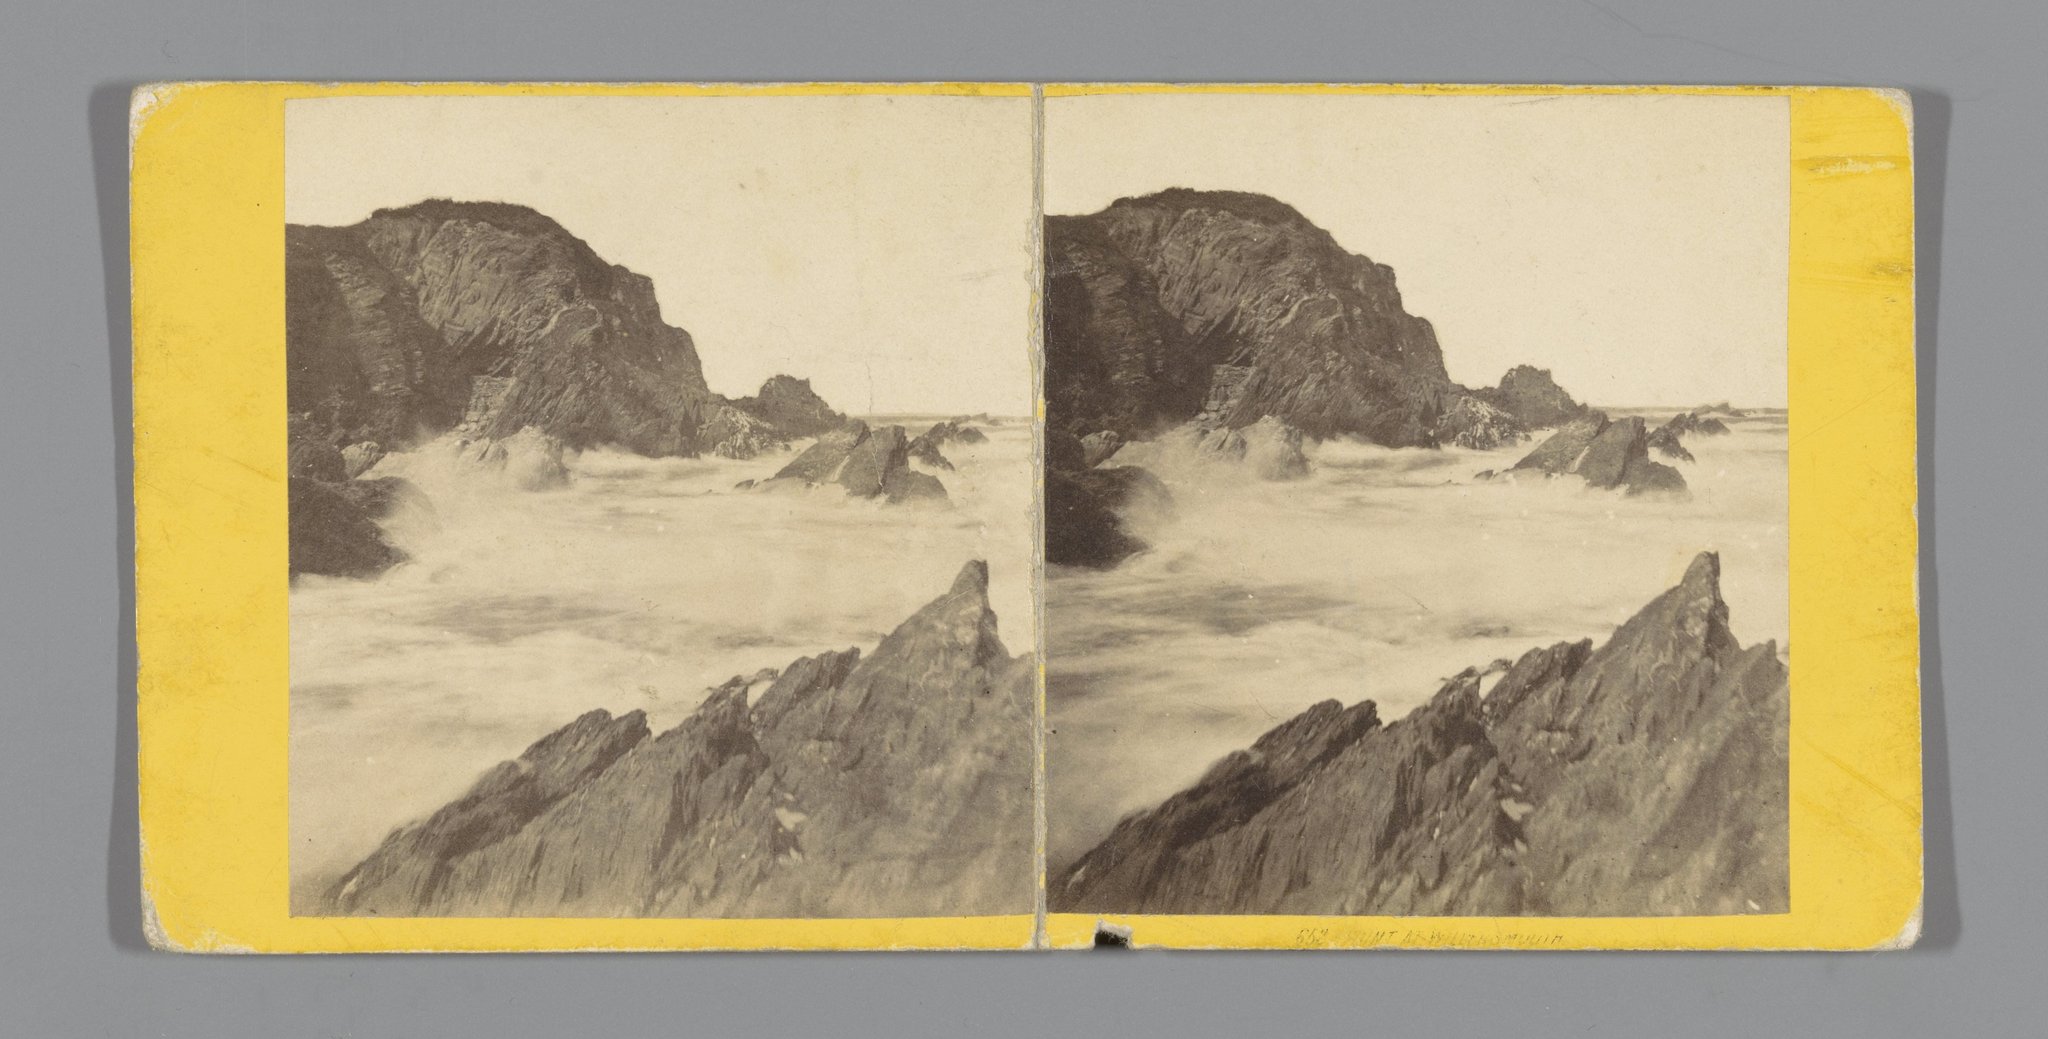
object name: stereograph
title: Point at Willsmouth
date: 1850-1880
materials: cardboard, photographic support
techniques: albumen print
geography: exeter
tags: rocky coast, sea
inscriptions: name: ‘William Spreat, Publisher, 229, High Street, Exeter.’, number: ‘552’